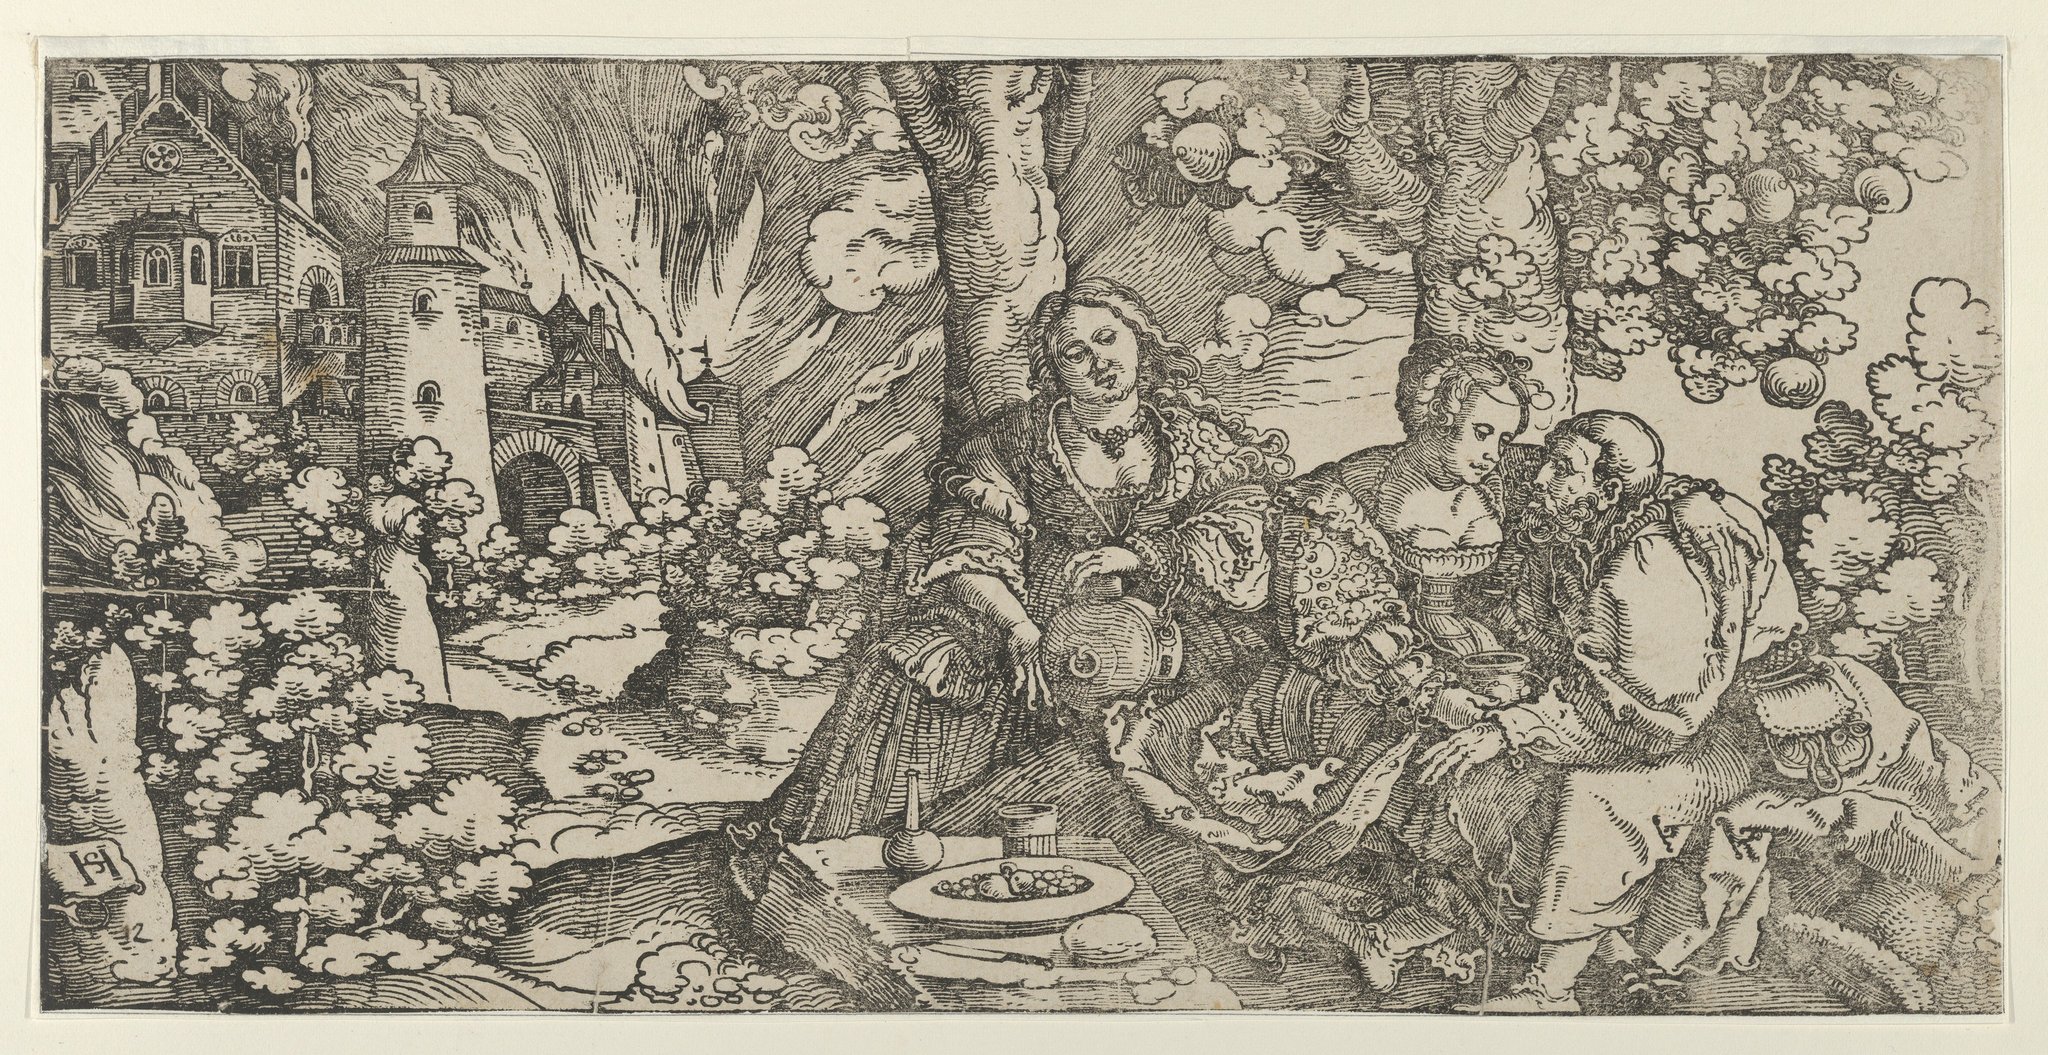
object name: print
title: Lot and his Daughters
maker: hans schäufelein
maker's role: artist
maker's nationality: german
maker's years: 1480-1540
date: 1530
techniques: woodcut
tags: fathers,women